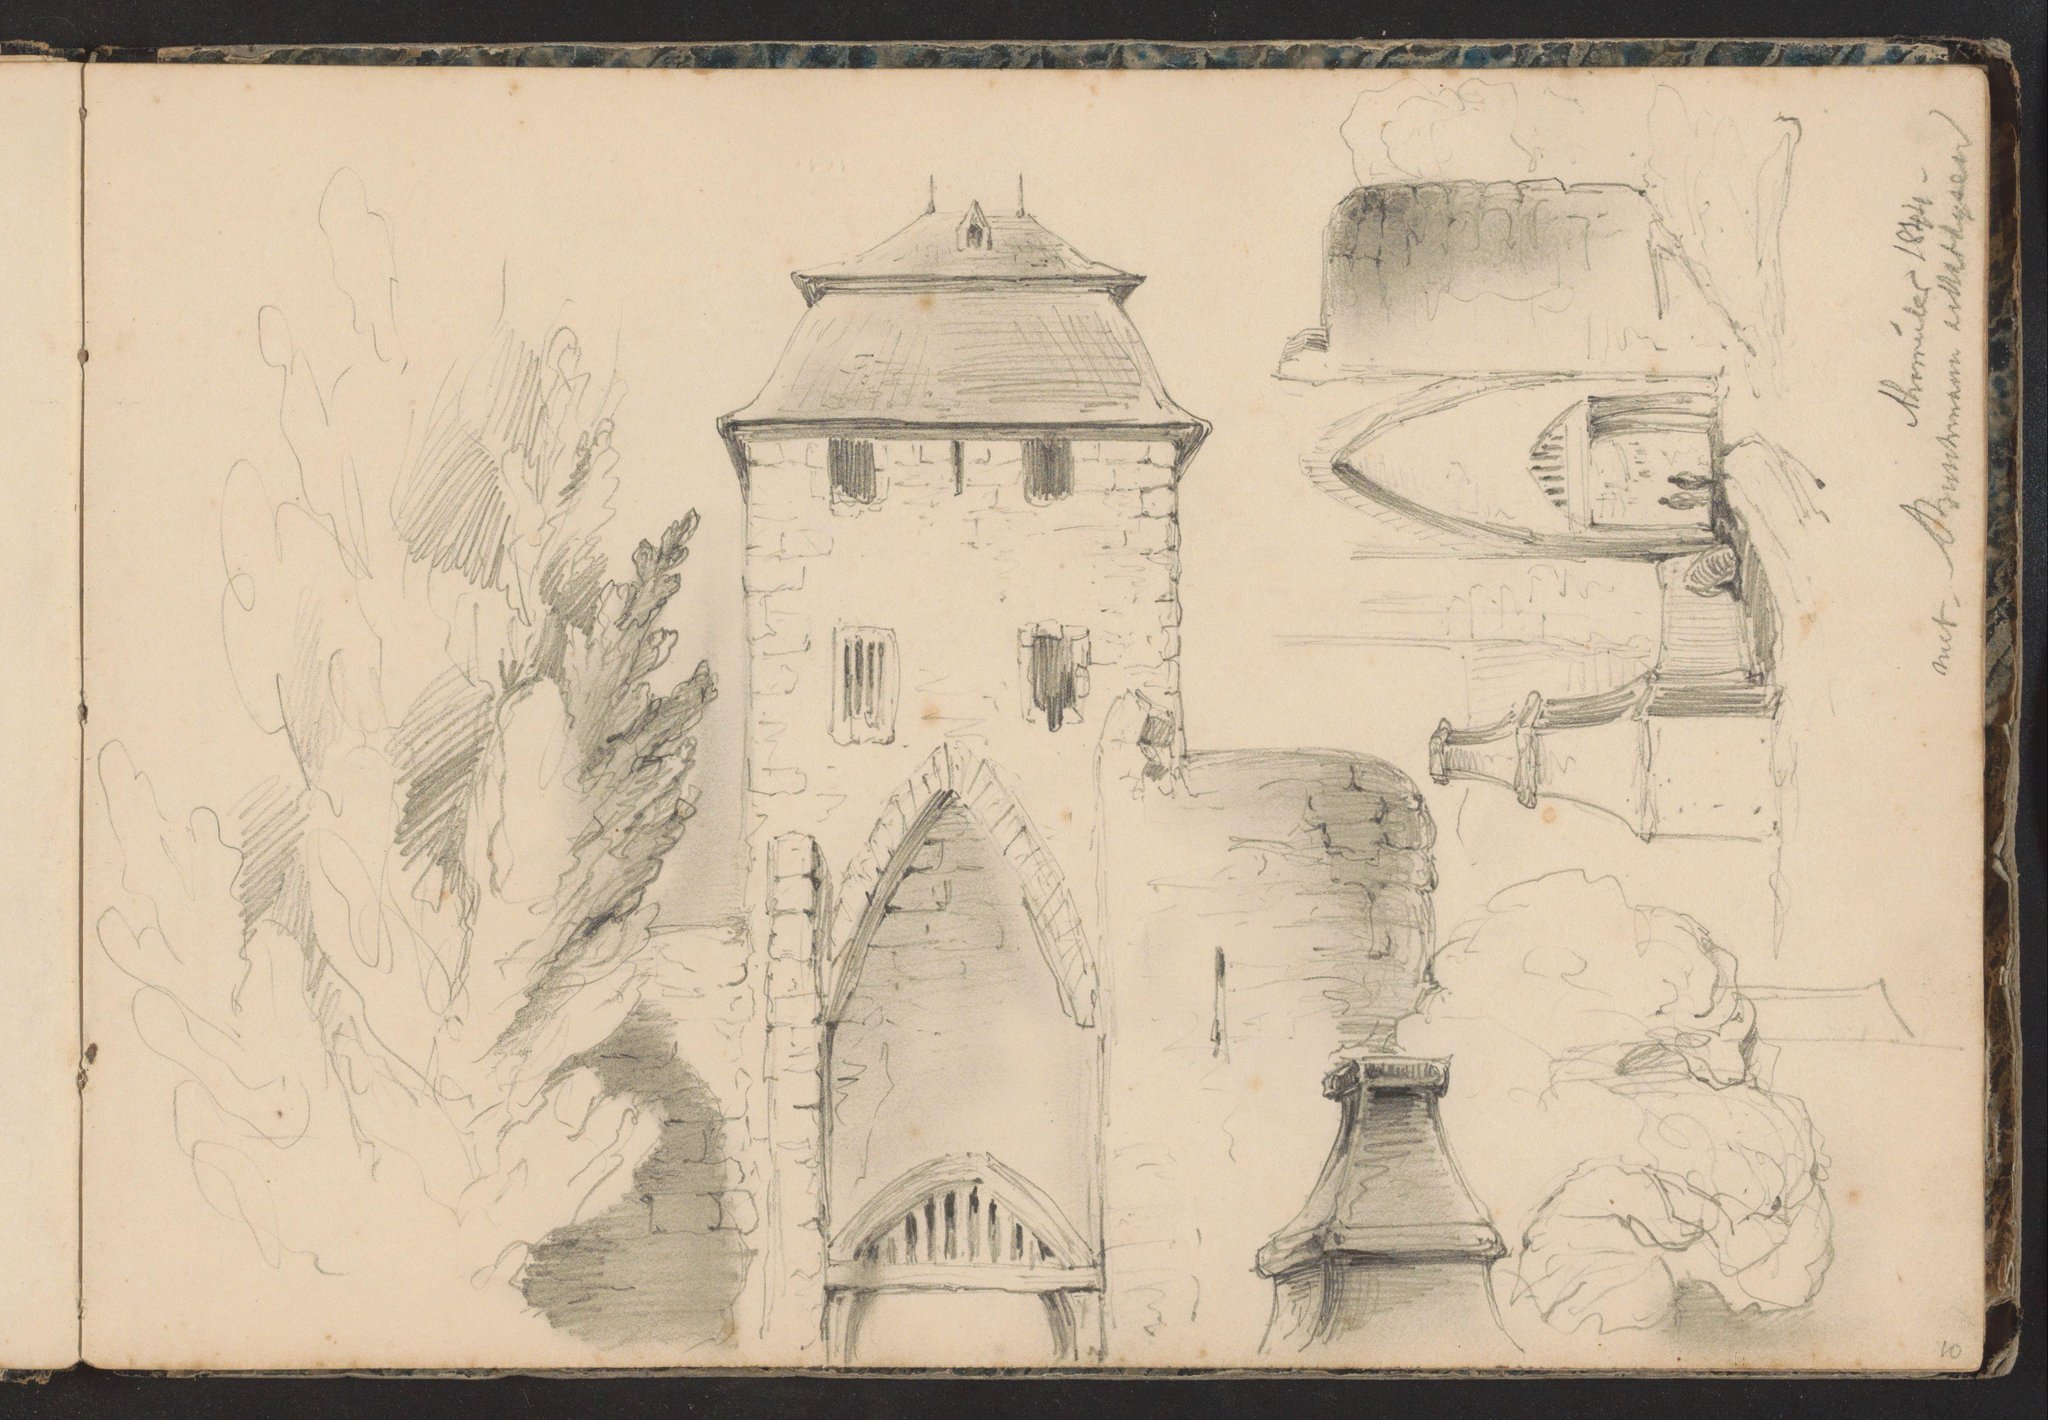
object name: sketchbook leaf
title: Toren van een stadspoort bij Ahrweiler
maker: johannes tavenraat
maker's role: draughtsman, painter, print maker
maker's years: 1809-1881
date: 1844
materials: paper, pencil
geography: rhineland-palatinate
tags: trees, gate, entrance, landscapes (+ landscape with figures, staffage)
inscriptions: date and inscription: ‘Ahrweiler 1844/ met Buschmann & Matthijsen’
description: Blad 10 recto uit een schetsboek met 44 bladen.